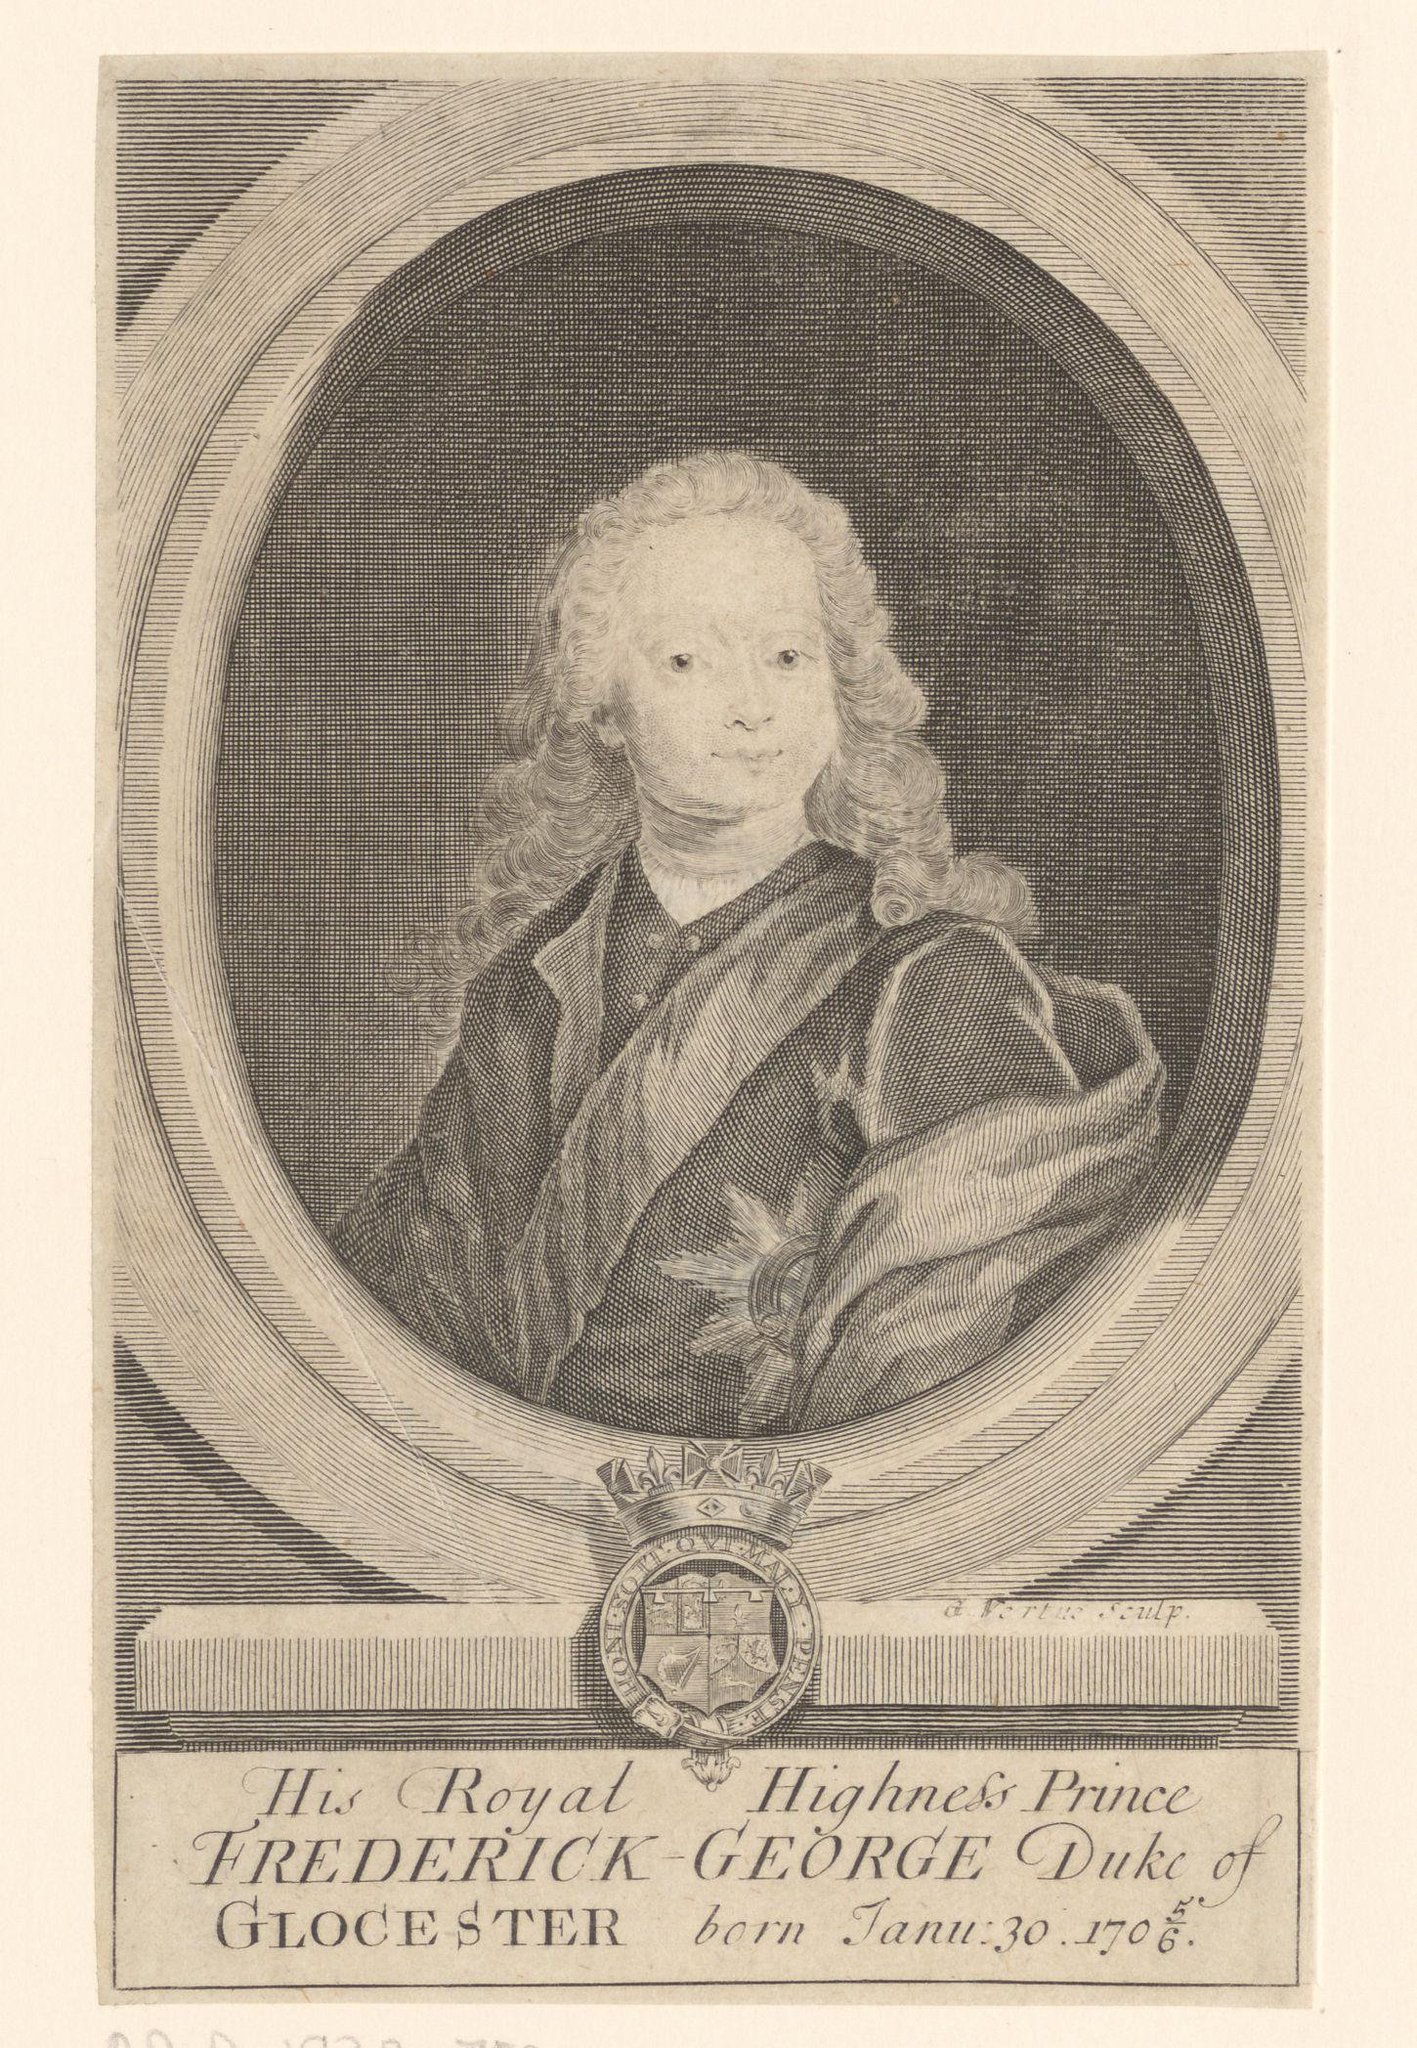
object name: print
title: Portret van Willem Frederik van Gloucester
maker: george vertue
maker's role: print maker, publisher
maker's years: 1684-1756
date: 1694-1756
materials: paper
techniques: engraving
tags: historical persons, officer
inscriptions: collector's mark: Lugt 2228